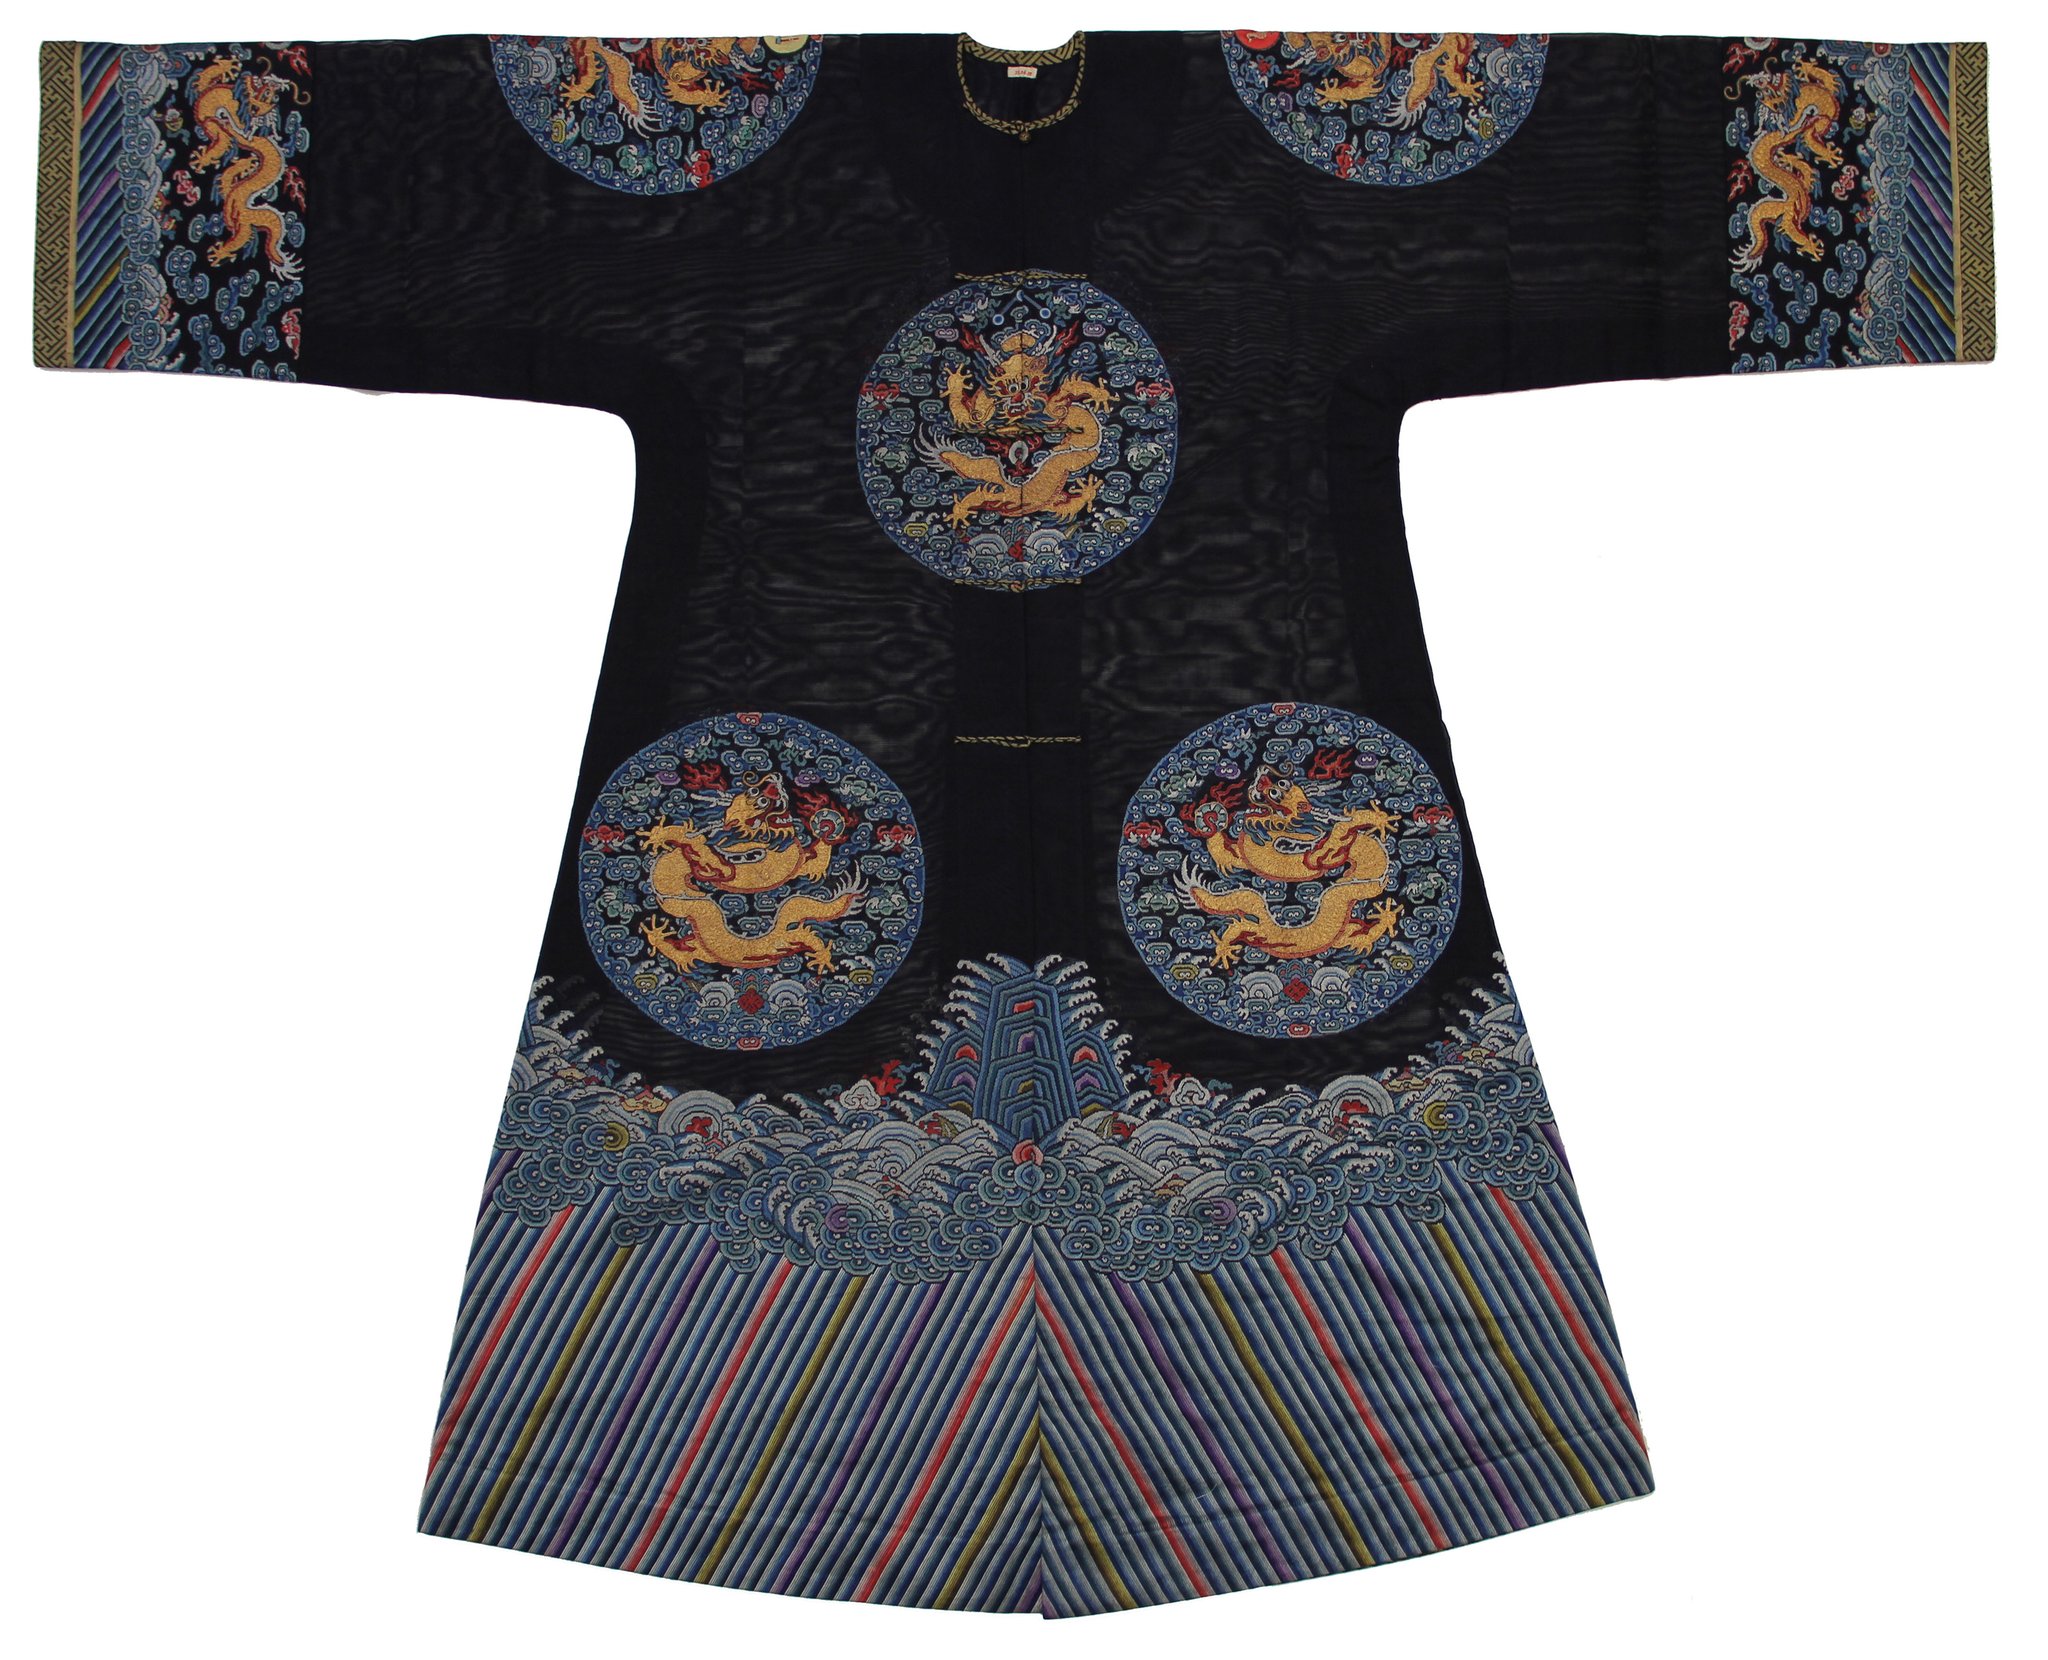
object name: coat, imperial, summer, for the empress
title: Imperial Summer Coat for the Empress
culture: chinese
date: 1801-1833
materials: metal thread, silk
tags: dragons